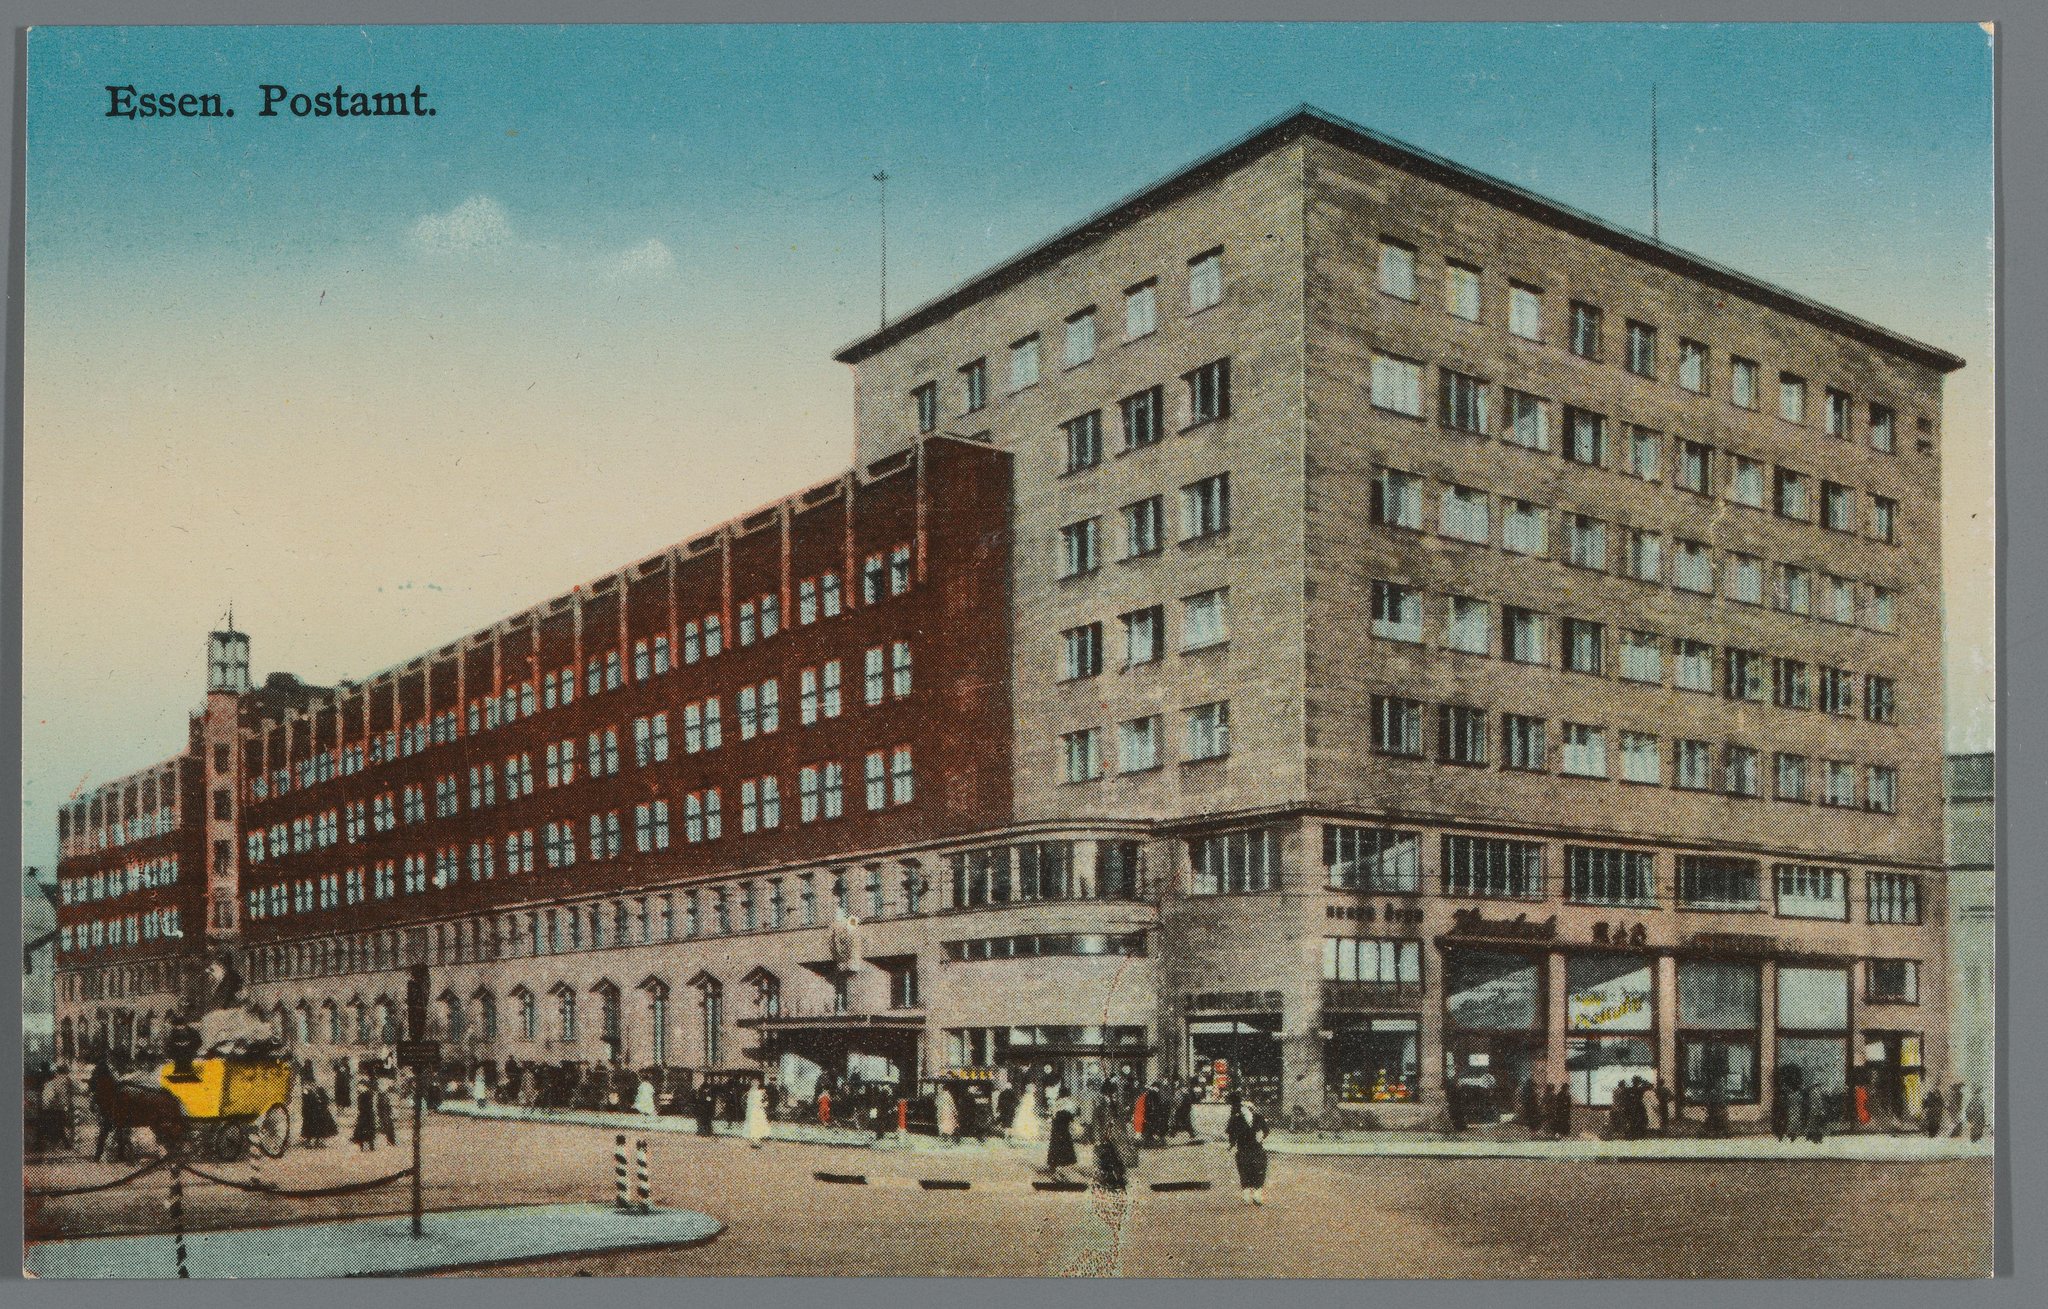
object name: postcard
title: Essen. Postamt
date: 1920-1950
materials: photographic support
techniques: autotype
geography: germany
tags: essen